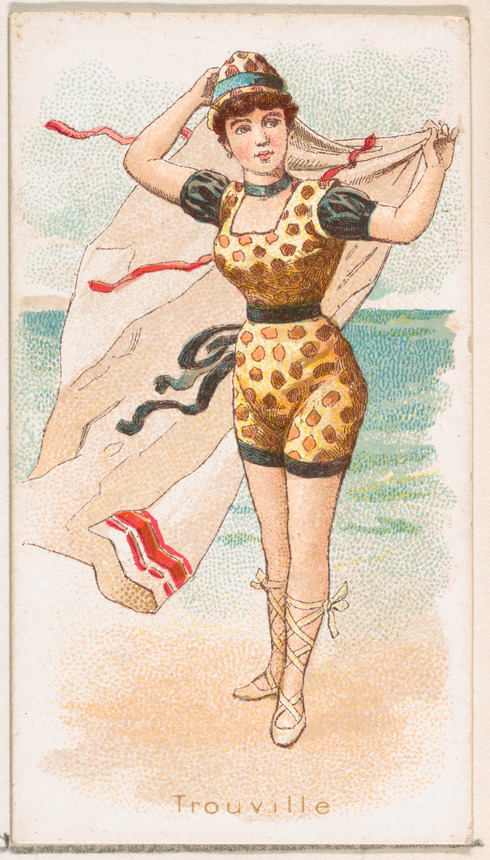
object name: print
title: Trouville, from the Fancy Bathers series (N187) issued by Wm. S. Kimball & Co.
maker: william s. kimball & company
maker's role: publisher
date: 1889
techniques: color lithograph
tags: women